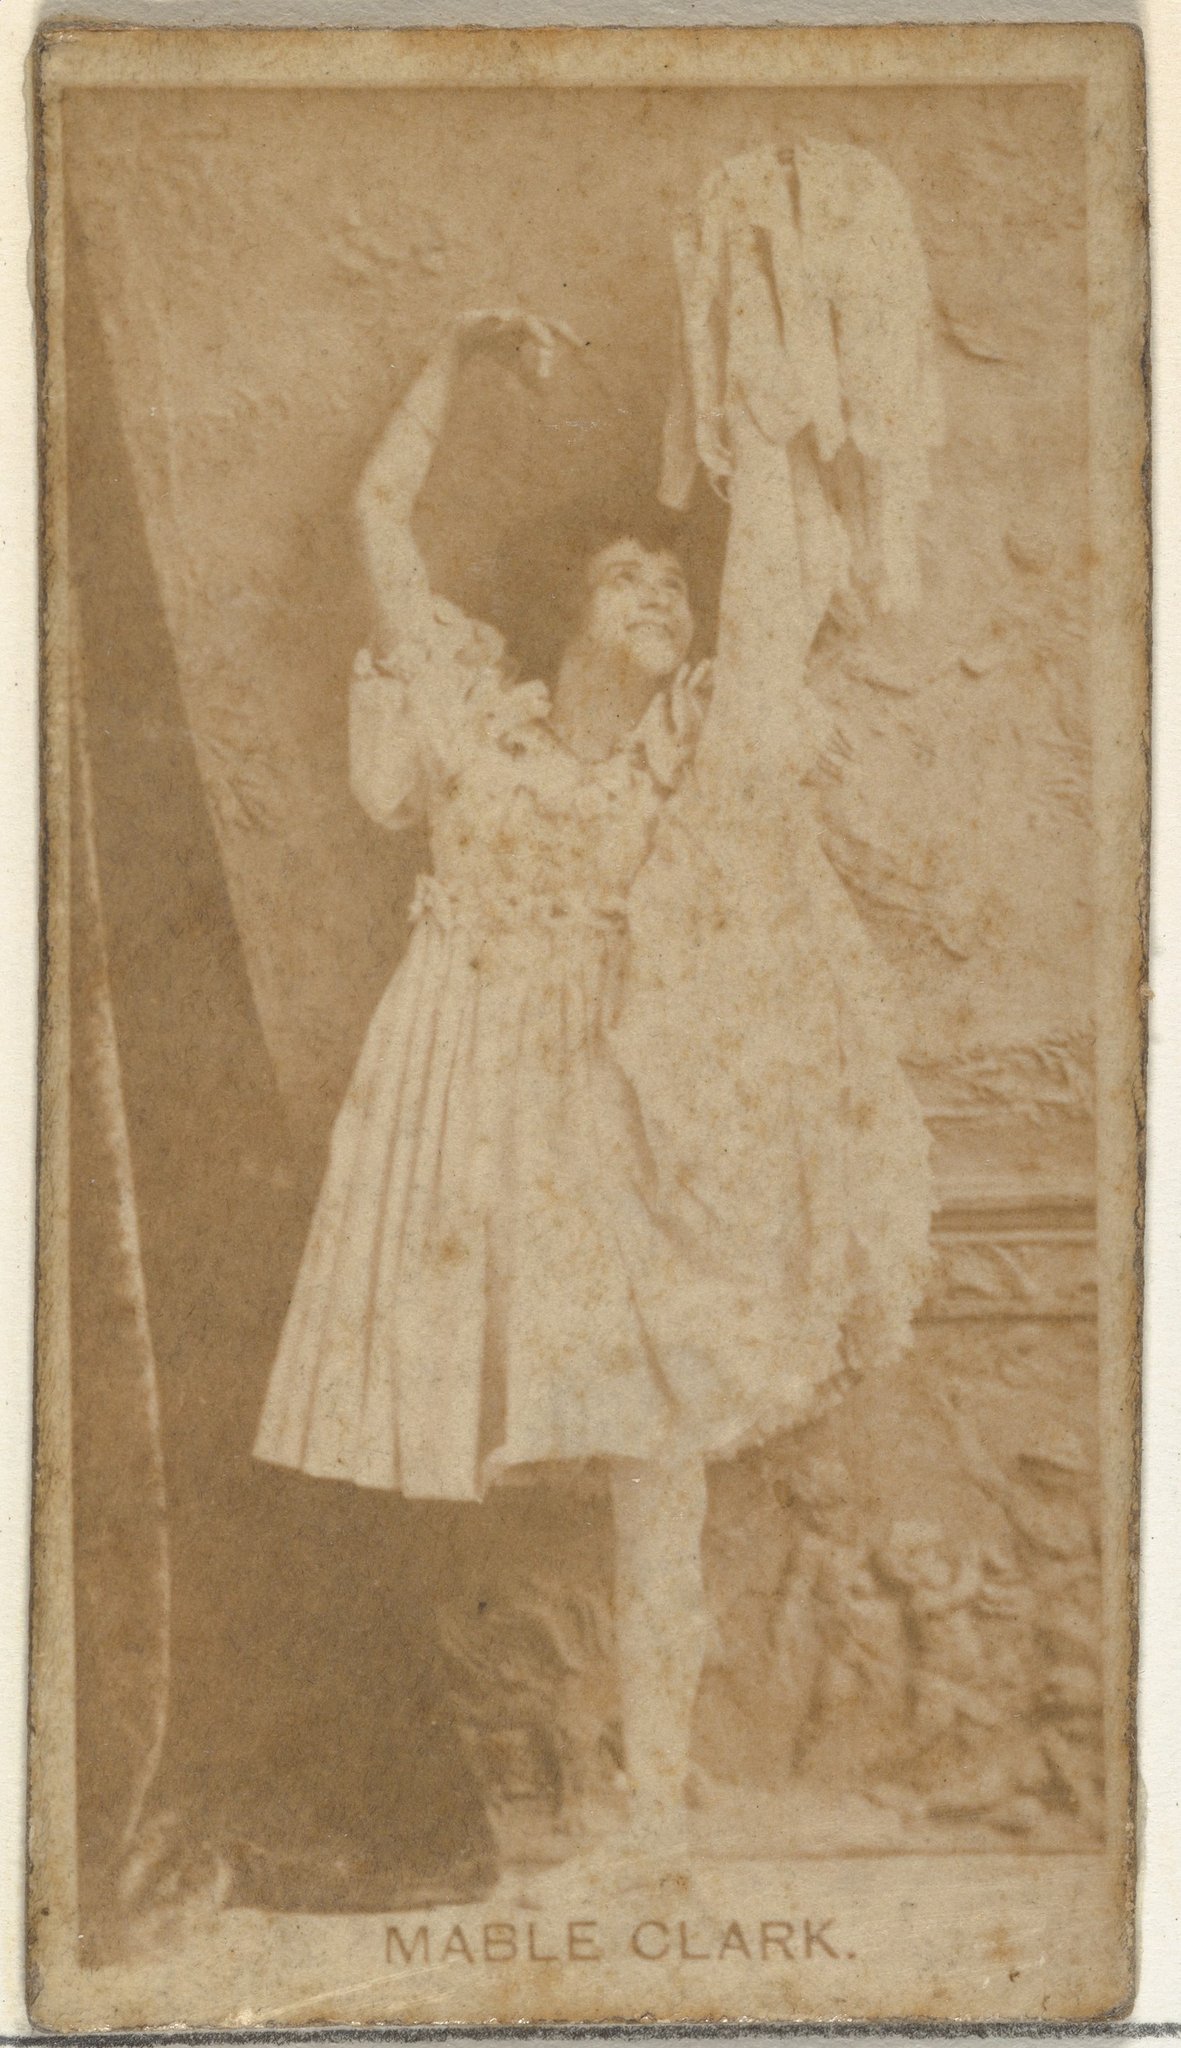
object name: photograph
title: Mable Clark, from the Actors and Actresses series (N145-8) issued by Duke Sons & Co. to promote Duke Cigarettes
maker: w. duke, sons & co.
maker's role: publisher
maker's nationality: american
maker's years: 1870-1920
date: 1891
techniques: albumen silver print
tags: portraits,women,actresses